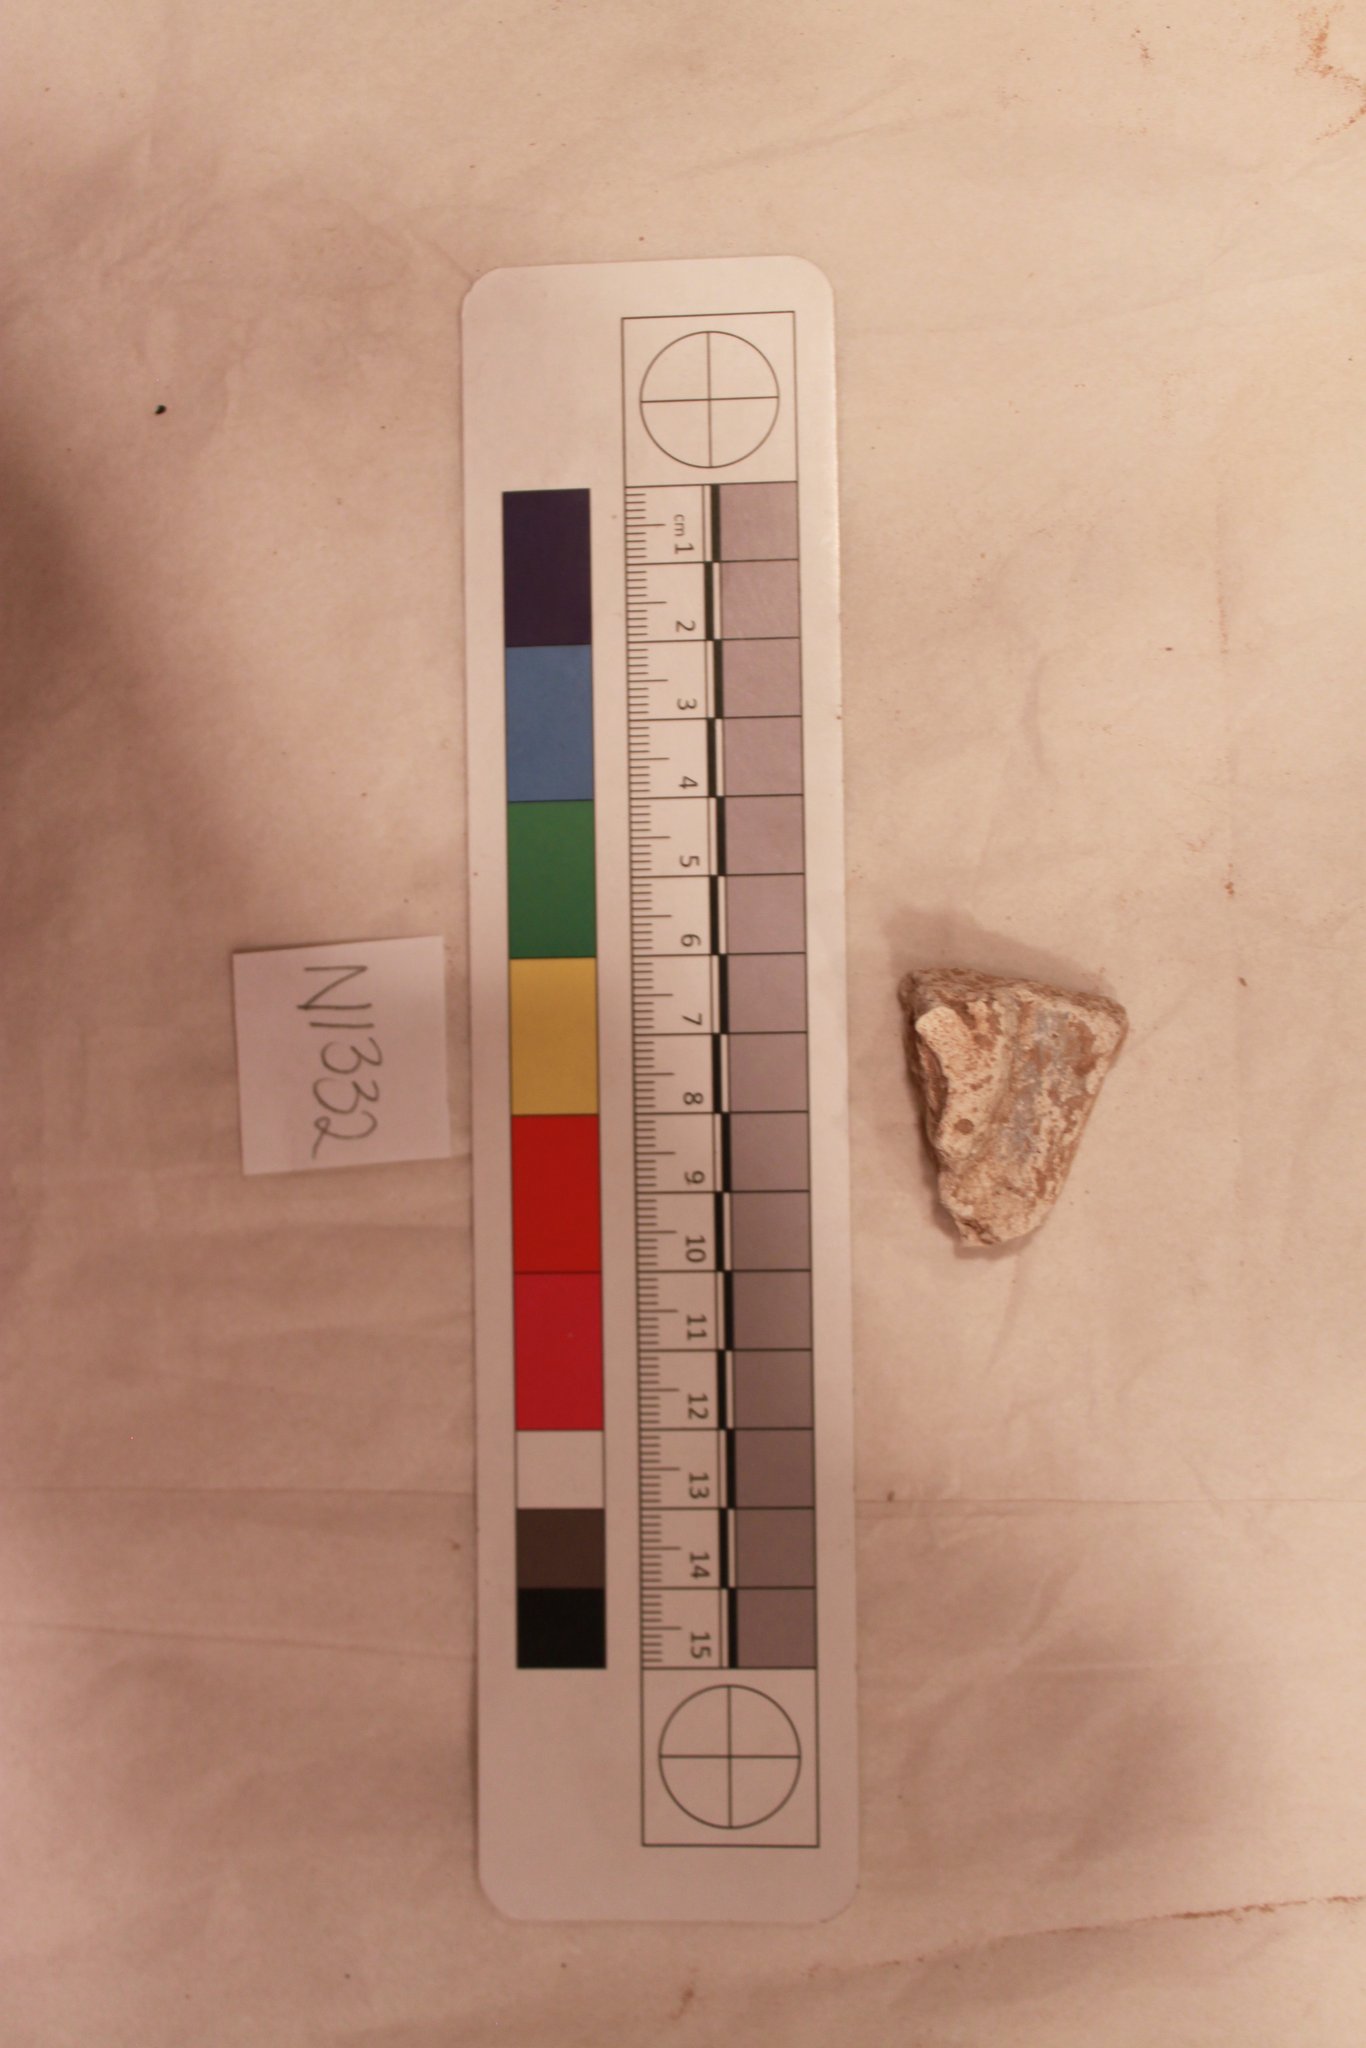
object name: fragment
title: Stucco Fragment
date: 701-1200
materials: plaster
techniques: carving, painting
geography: iran